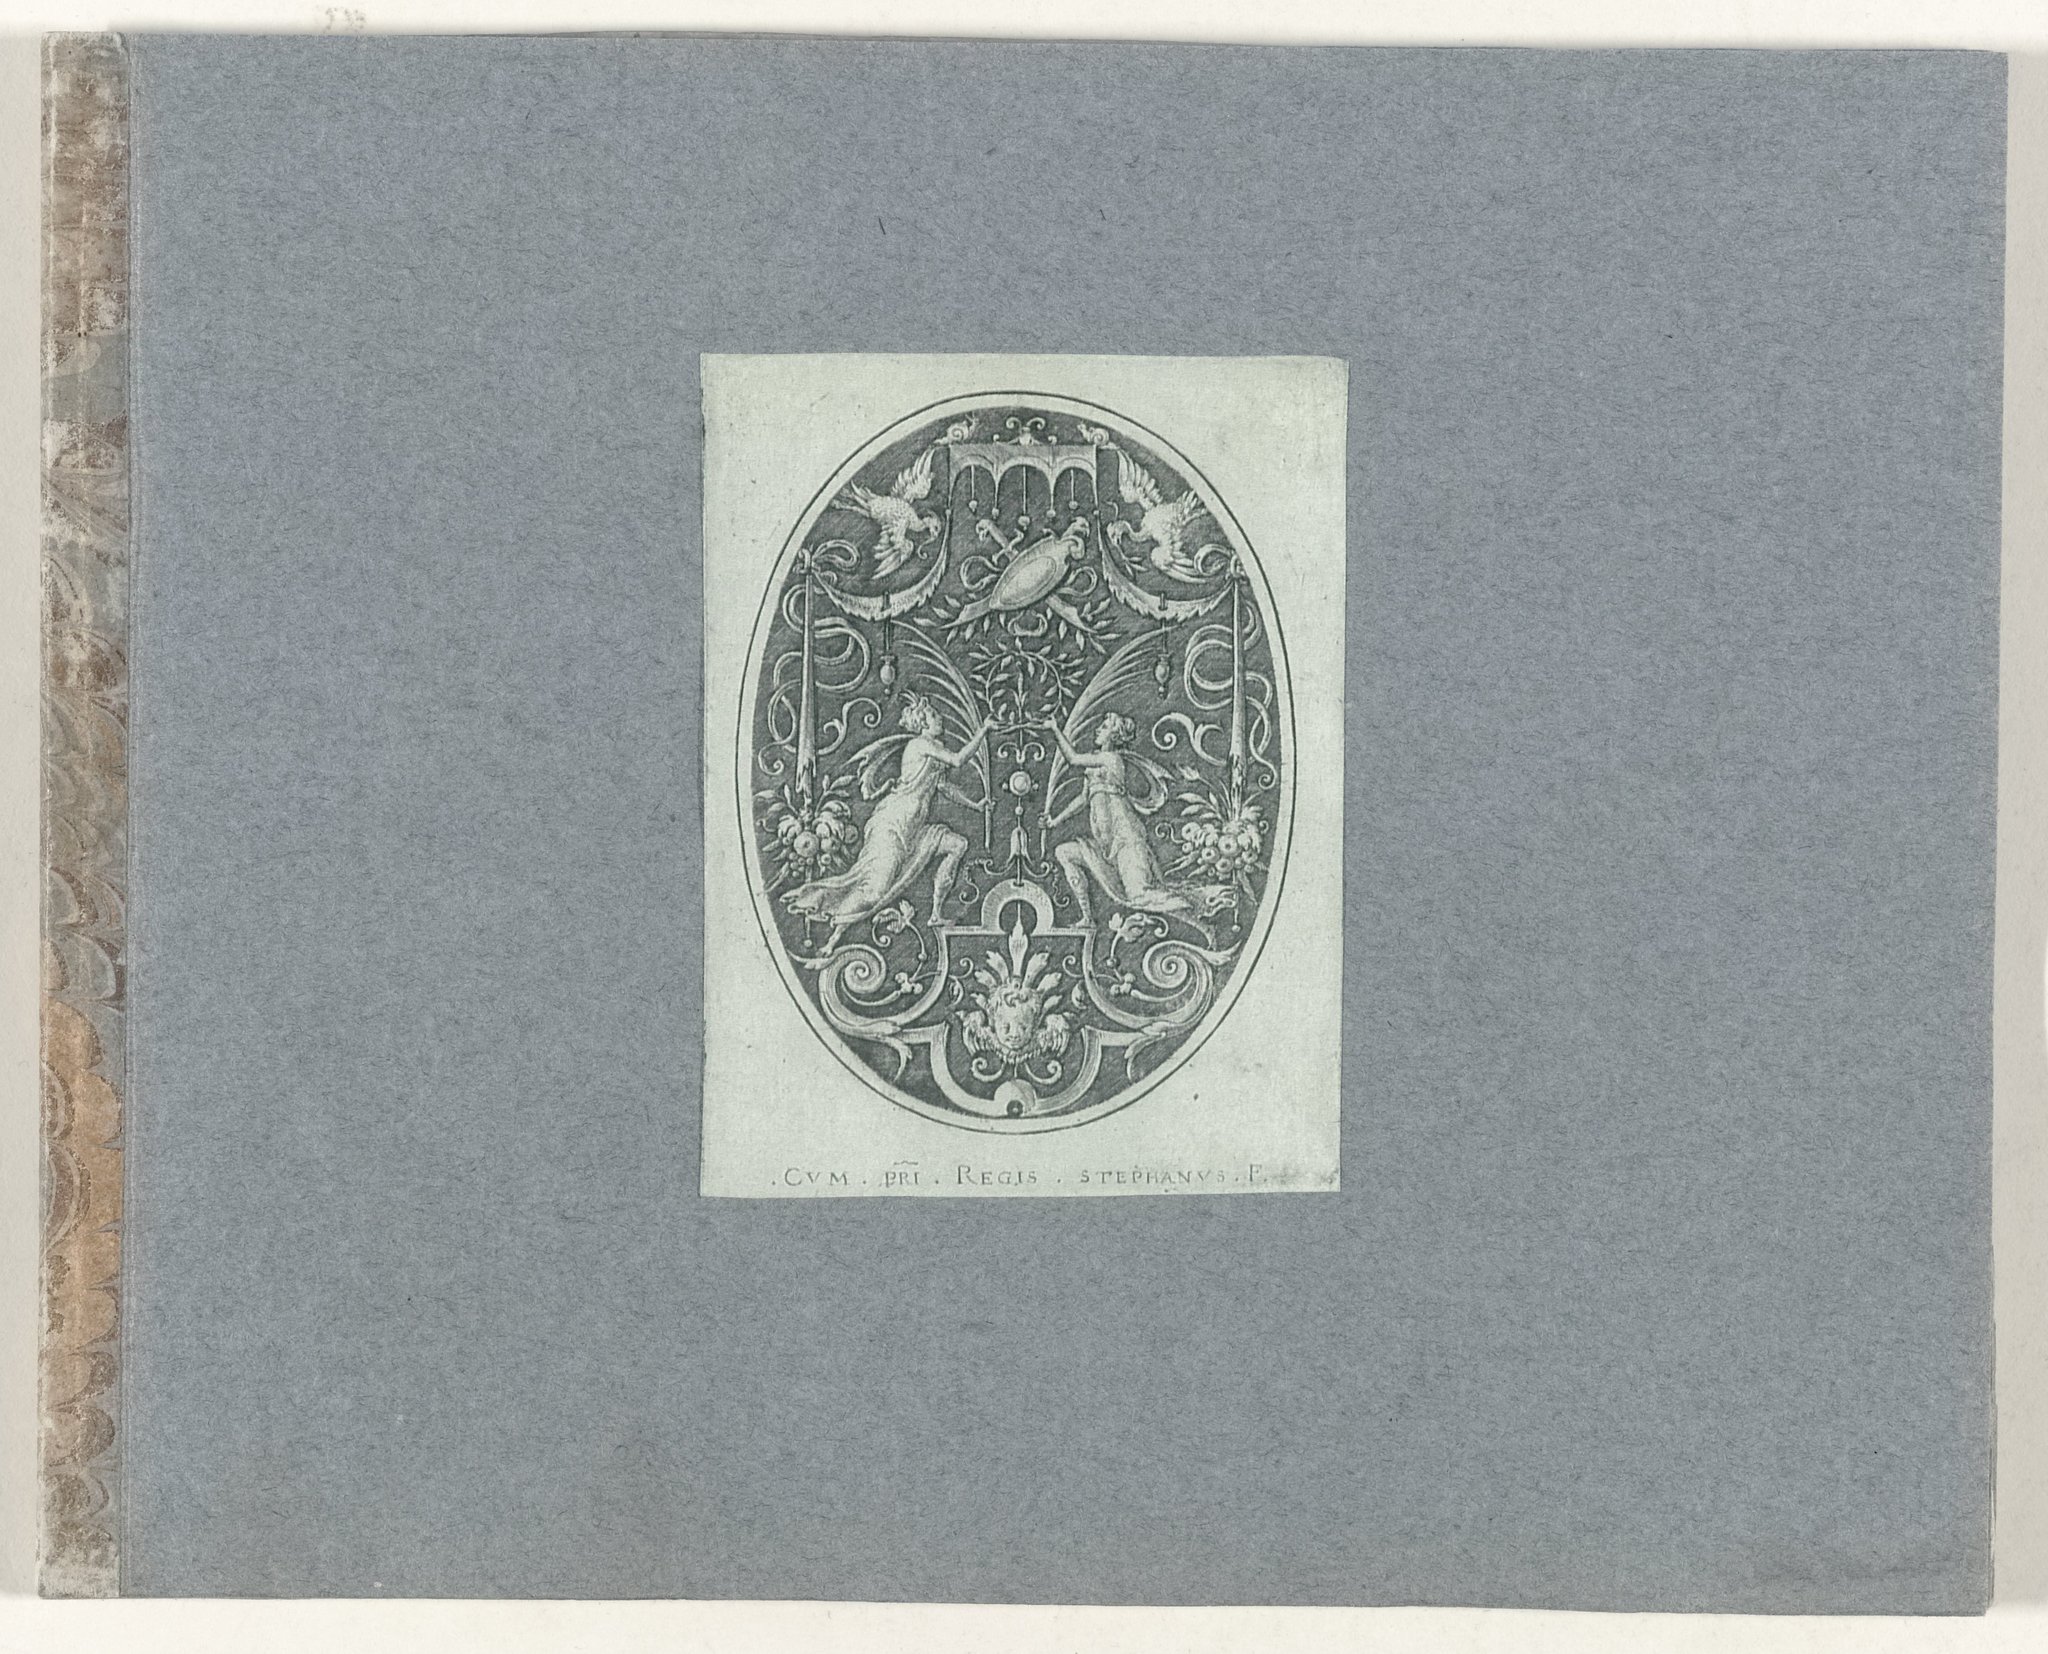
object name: print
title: Spits-boeck Dienstich den Gout en Silversmeden om te Snijden en te Dryven door P.R.K., samengebonden met zes andere ornamentprenten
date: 1560-1620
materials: paper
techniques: engraving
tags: ornaments ~ art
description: Een reeks van vijf genummerde ornamentprenten, inclusief titelblad met voorstellingen van goud- en zilversmeden: 'Spits-boeck Dienstich den Gout en Silversmeden om te Snijden en te Dryven door P.R.K.', samengebonden met zes andere ornamentprenten van Delaune en een anonieme meester.